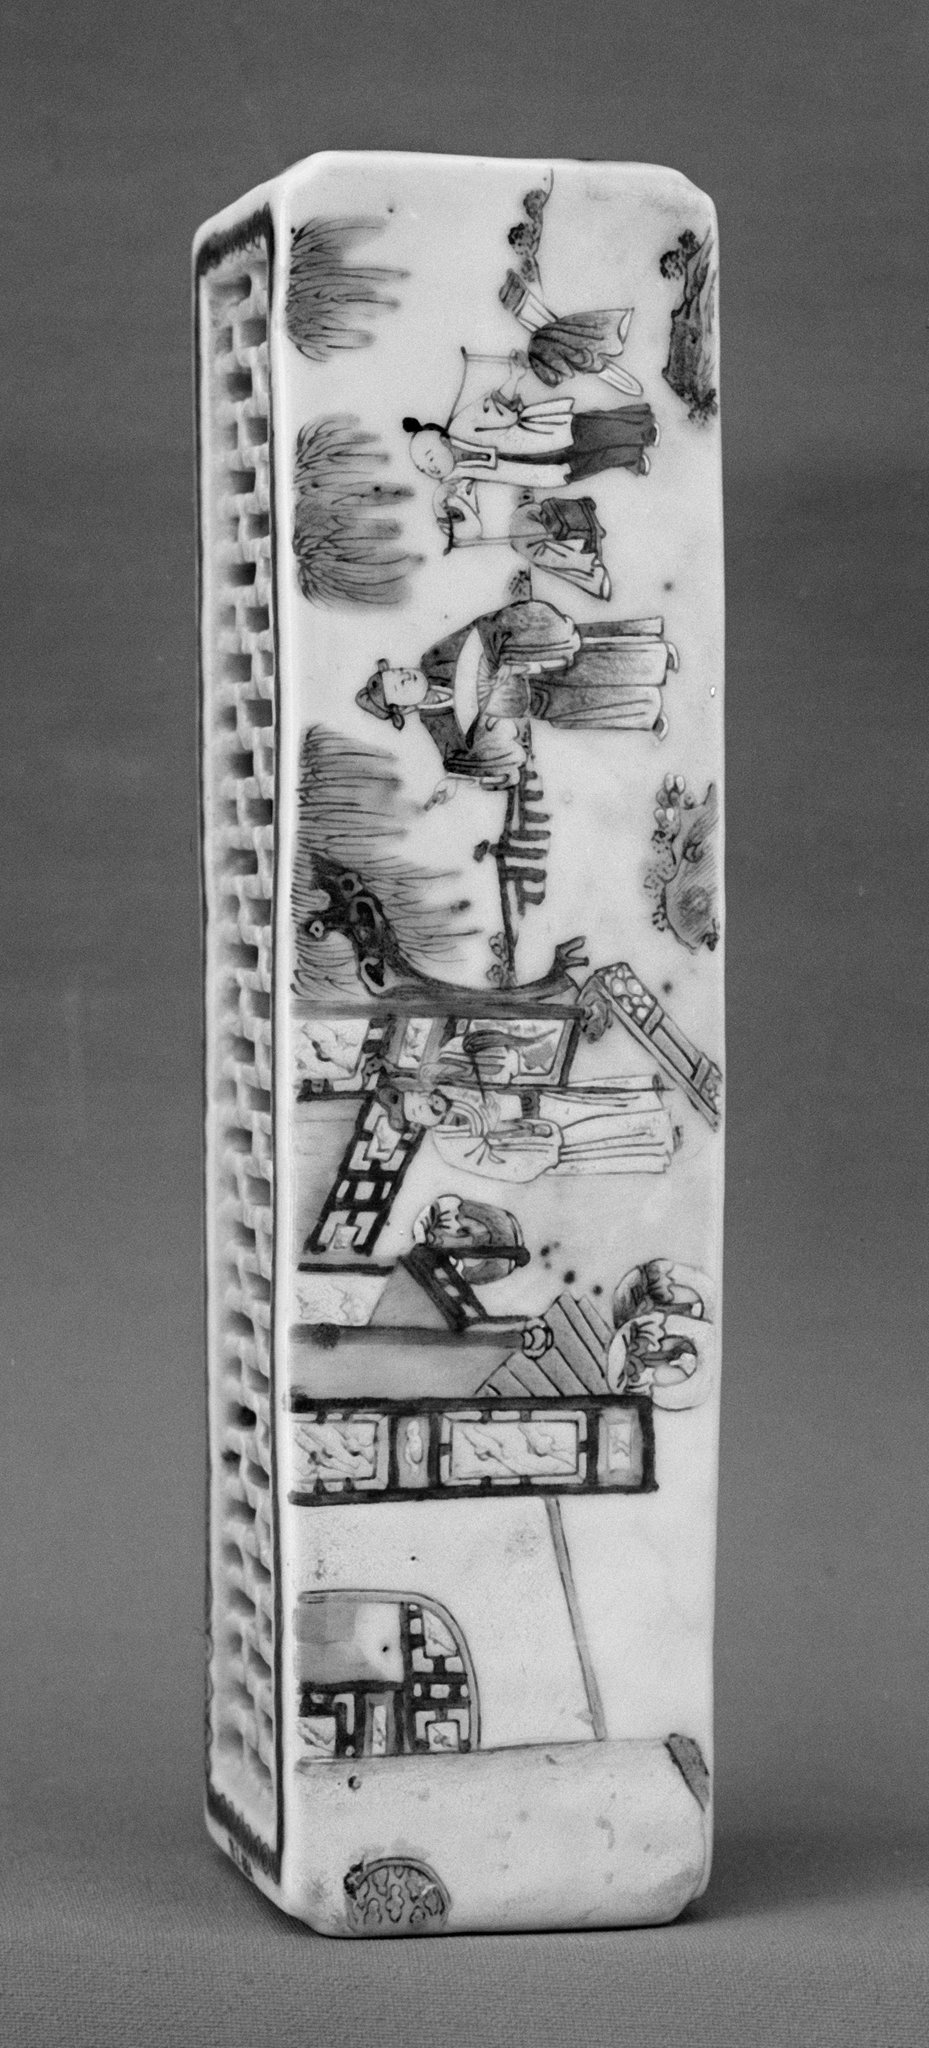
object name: incense box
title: Incense box with figures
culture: chinese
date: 1801-1850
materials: enamel, porcelain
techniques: overglaze, painting, polychrome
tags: men